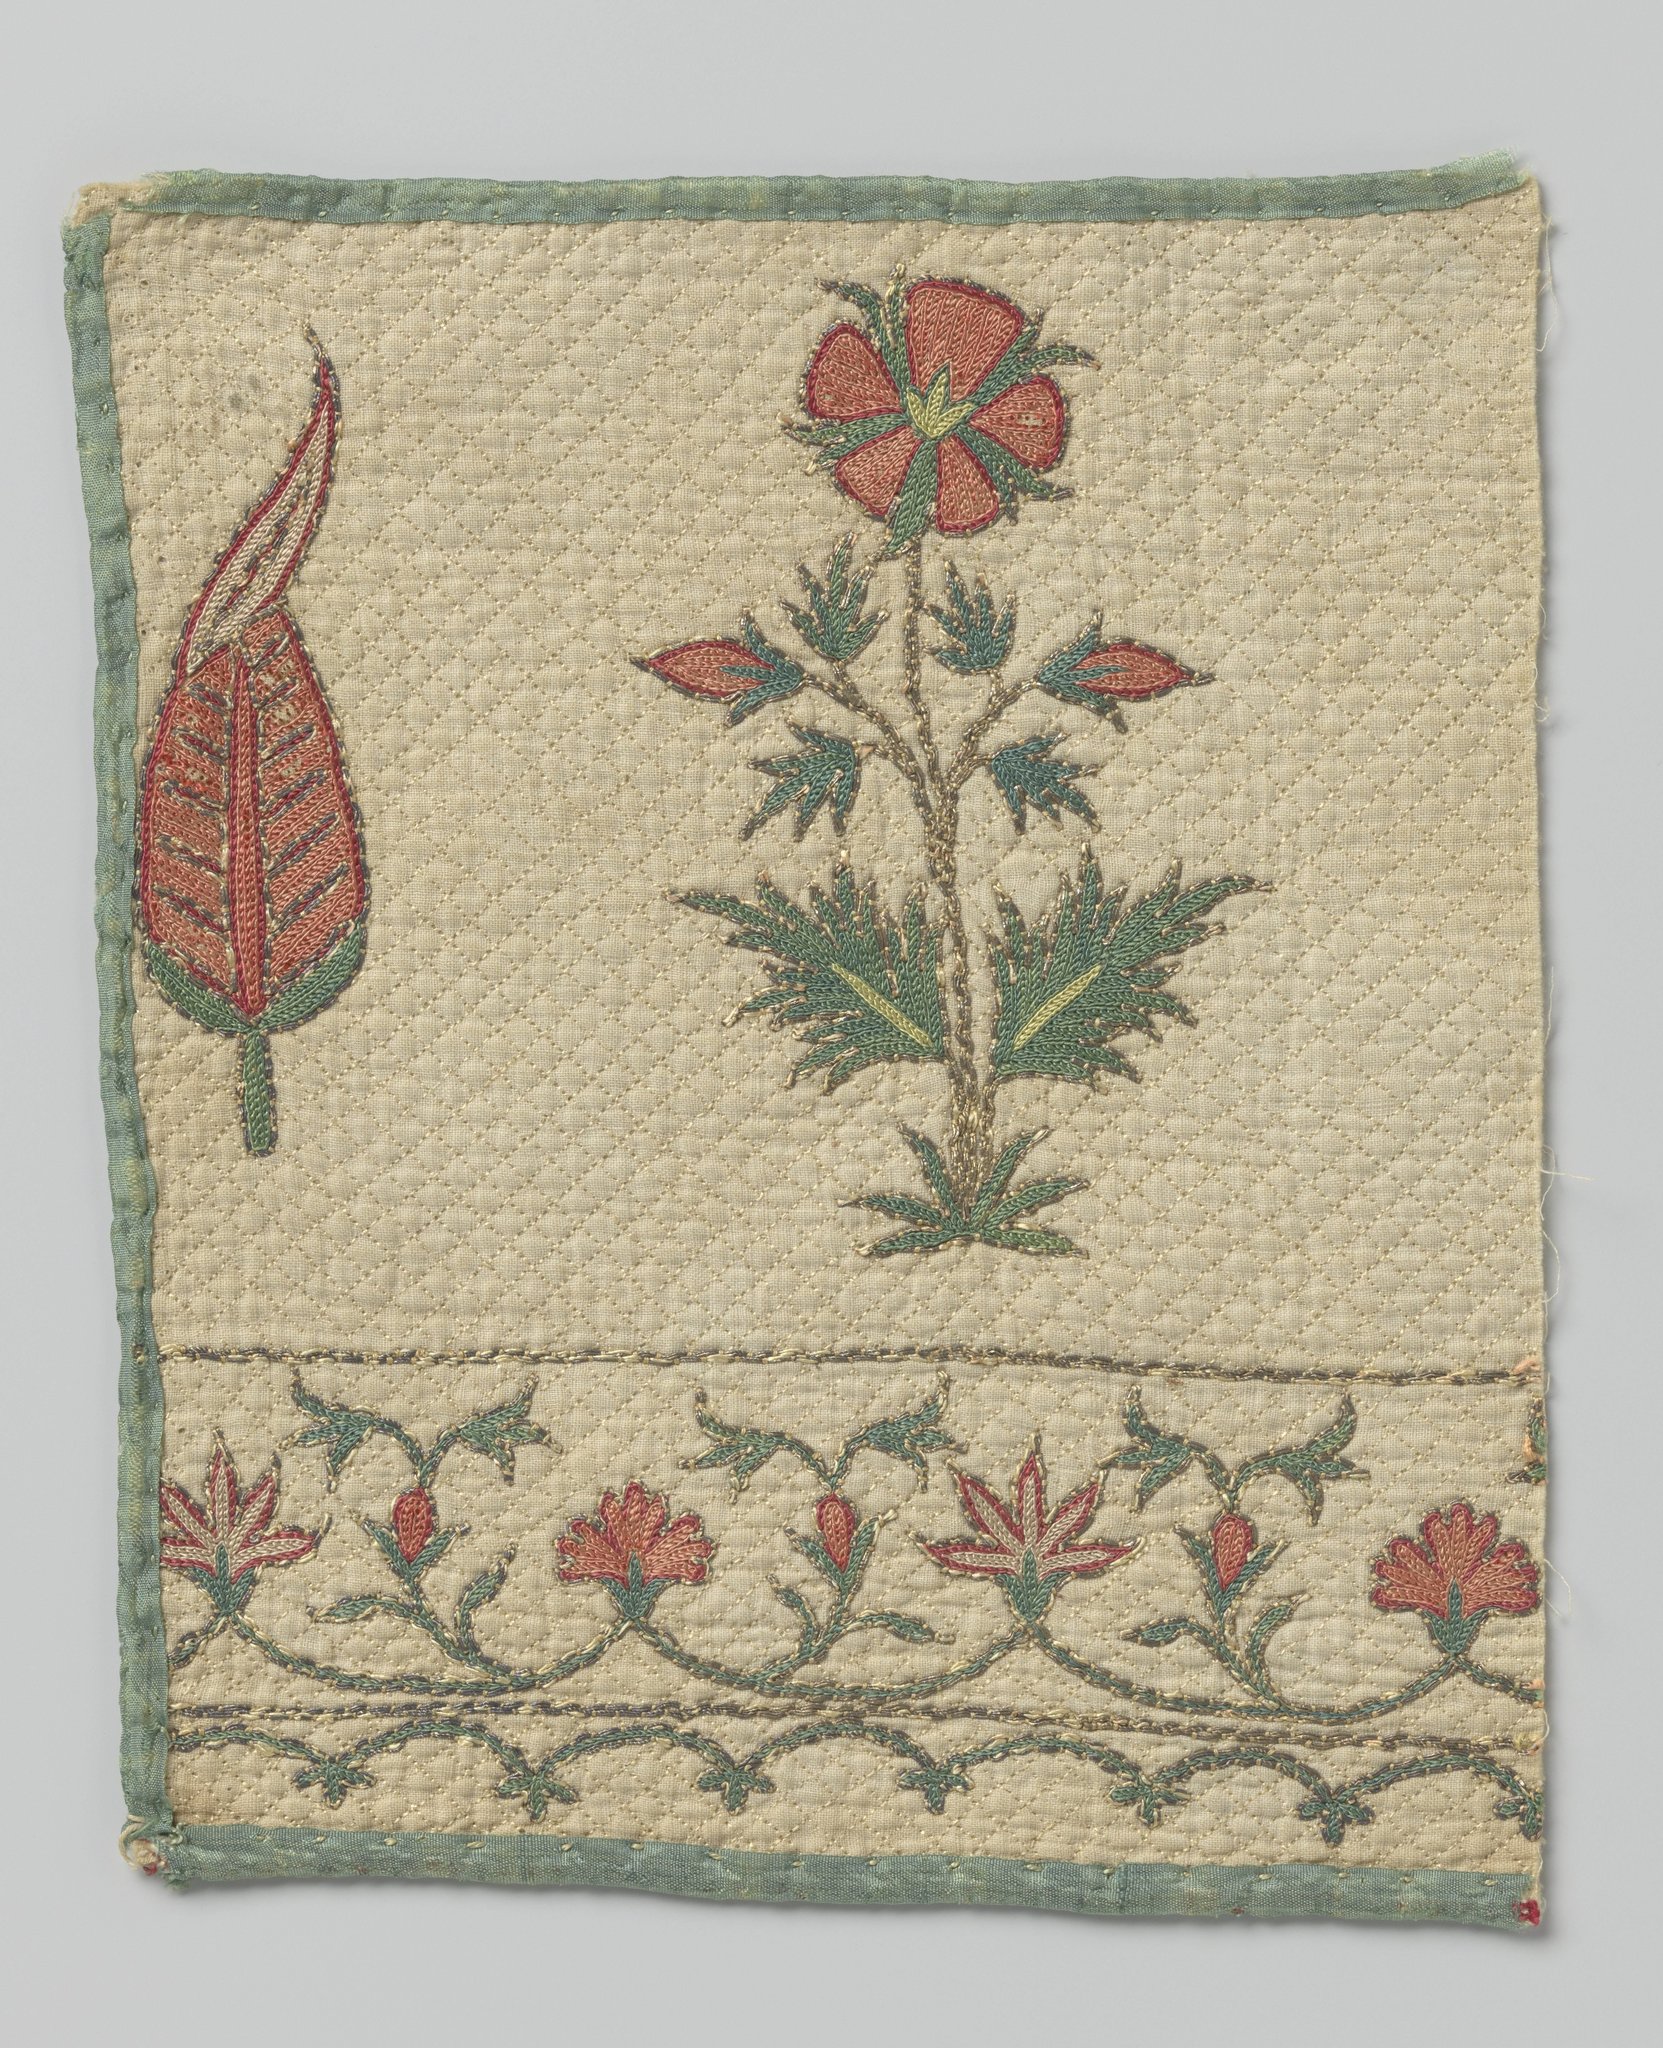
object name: embroidery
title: Fragment weefsel met borduurwerk.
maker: Anonymous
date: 1500-1899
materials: cotton, metal thread, silk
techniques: embroidered, weave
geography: netherlands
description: Fragment wit weefsel met borduurwerk in rood en groen en metaaldraad. Het patroon heeft langs de onderrand een ornamentrand met een gestileerde bloem- en bladslinger. Boven de rand is een blad en een plant geborduurd.